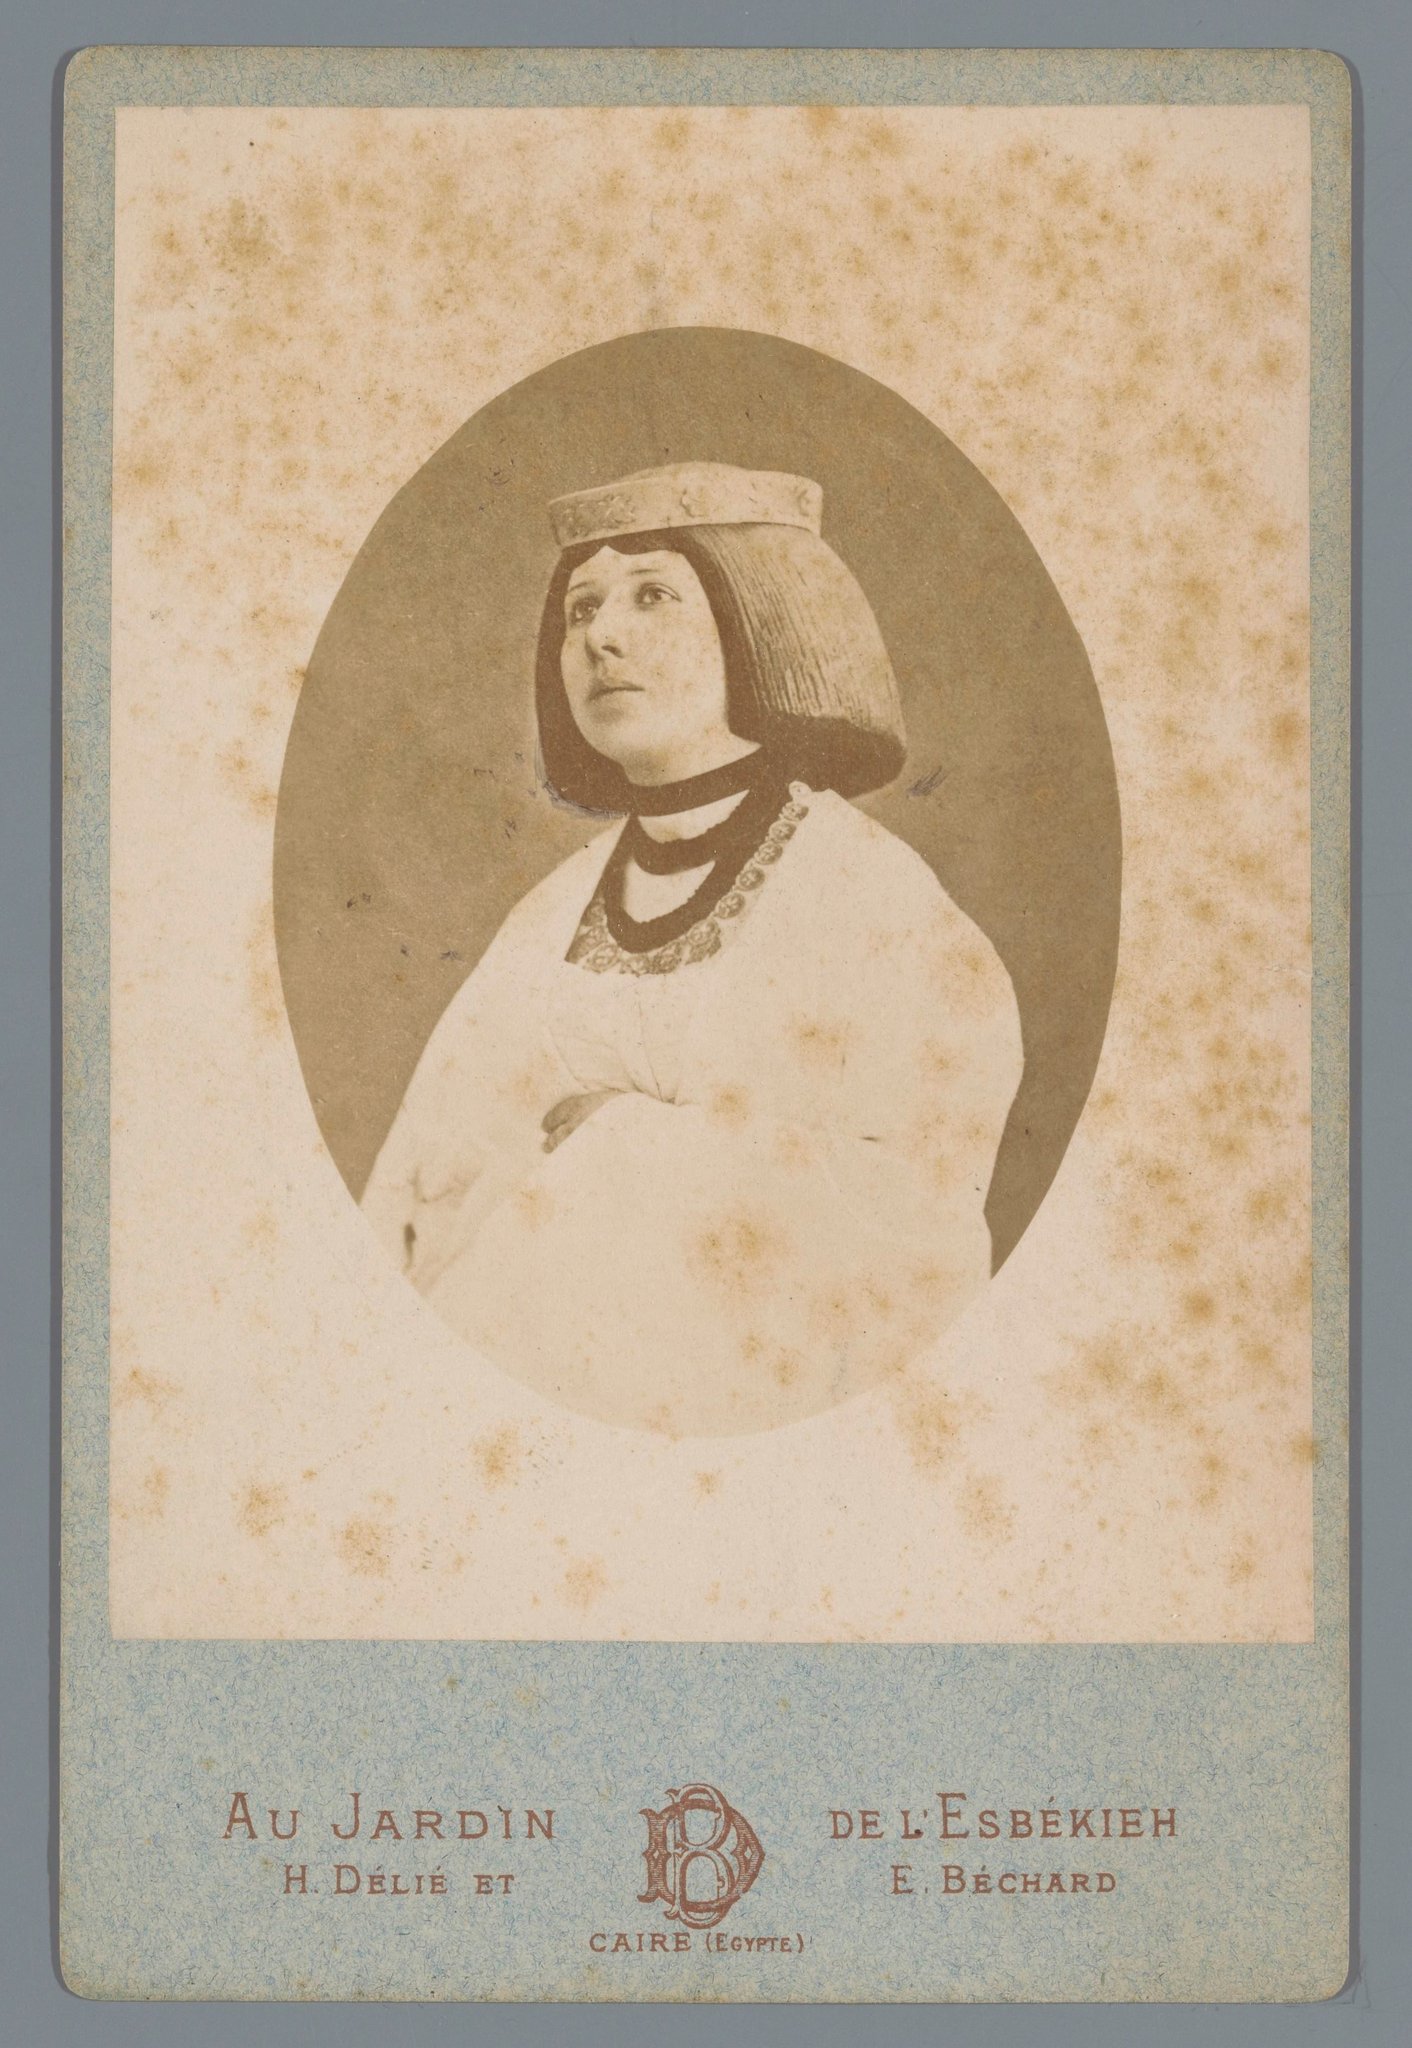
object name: cabinet photograph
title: Portret van een onbekende vrouw met pruik en hoofddeksel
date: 1869-1890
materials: cardboard, photographic support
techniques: albumen print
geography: cairo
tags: wig - aa - ~ women, anonymous historical person portrayed - bb - woman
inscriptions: inscription: ‘Au Jardin/ de l'Esbékieh/ H. Délié & E. Béchard/ Caire/ Egypte/ Les Clichés Sont Conservés.’